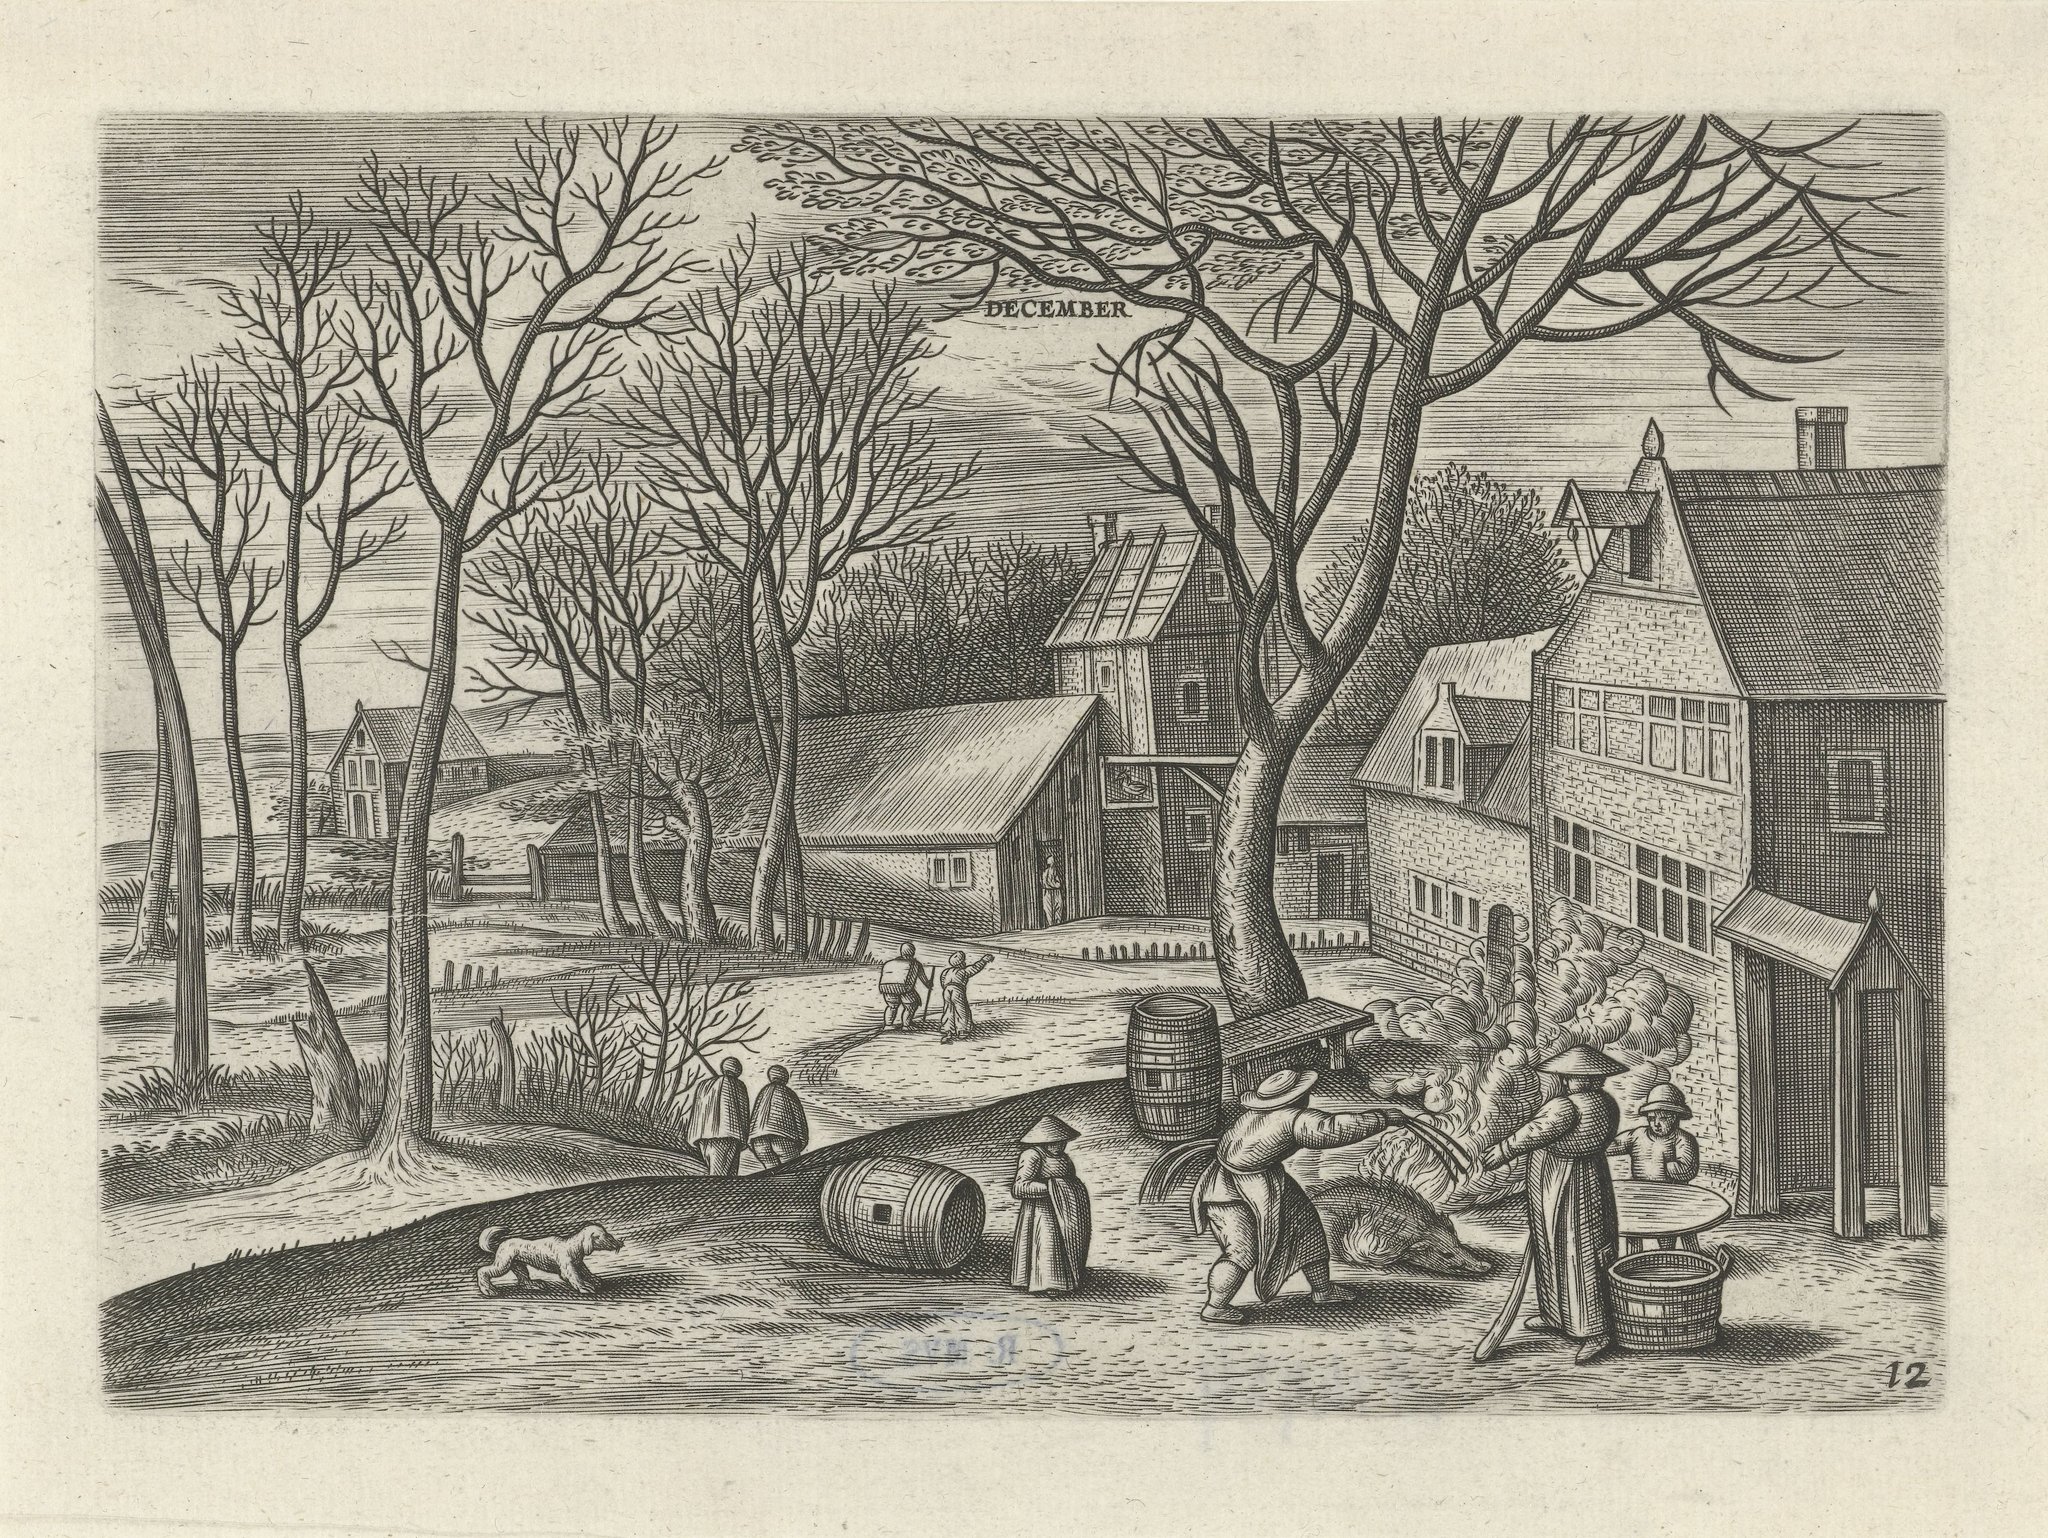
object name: print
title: December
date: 1596-1652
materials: paper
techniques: engraving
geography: antwerp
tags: january and its 'labours', conserving, preserving, e.g.: canning, salt (+ preserved foods)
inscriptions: collector's mark: Lugt 2228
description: Winterlandschap met wintertaferelen. December is de slachtmaand. Op de voorgrond wordt een varken gerookt door een familie. Deel van een serie van de twaalf maanden, waarbij elke maand wordt afgebeeld met de voor haar typerende menselijke activiteiten en haar klimatologische kenmerken.